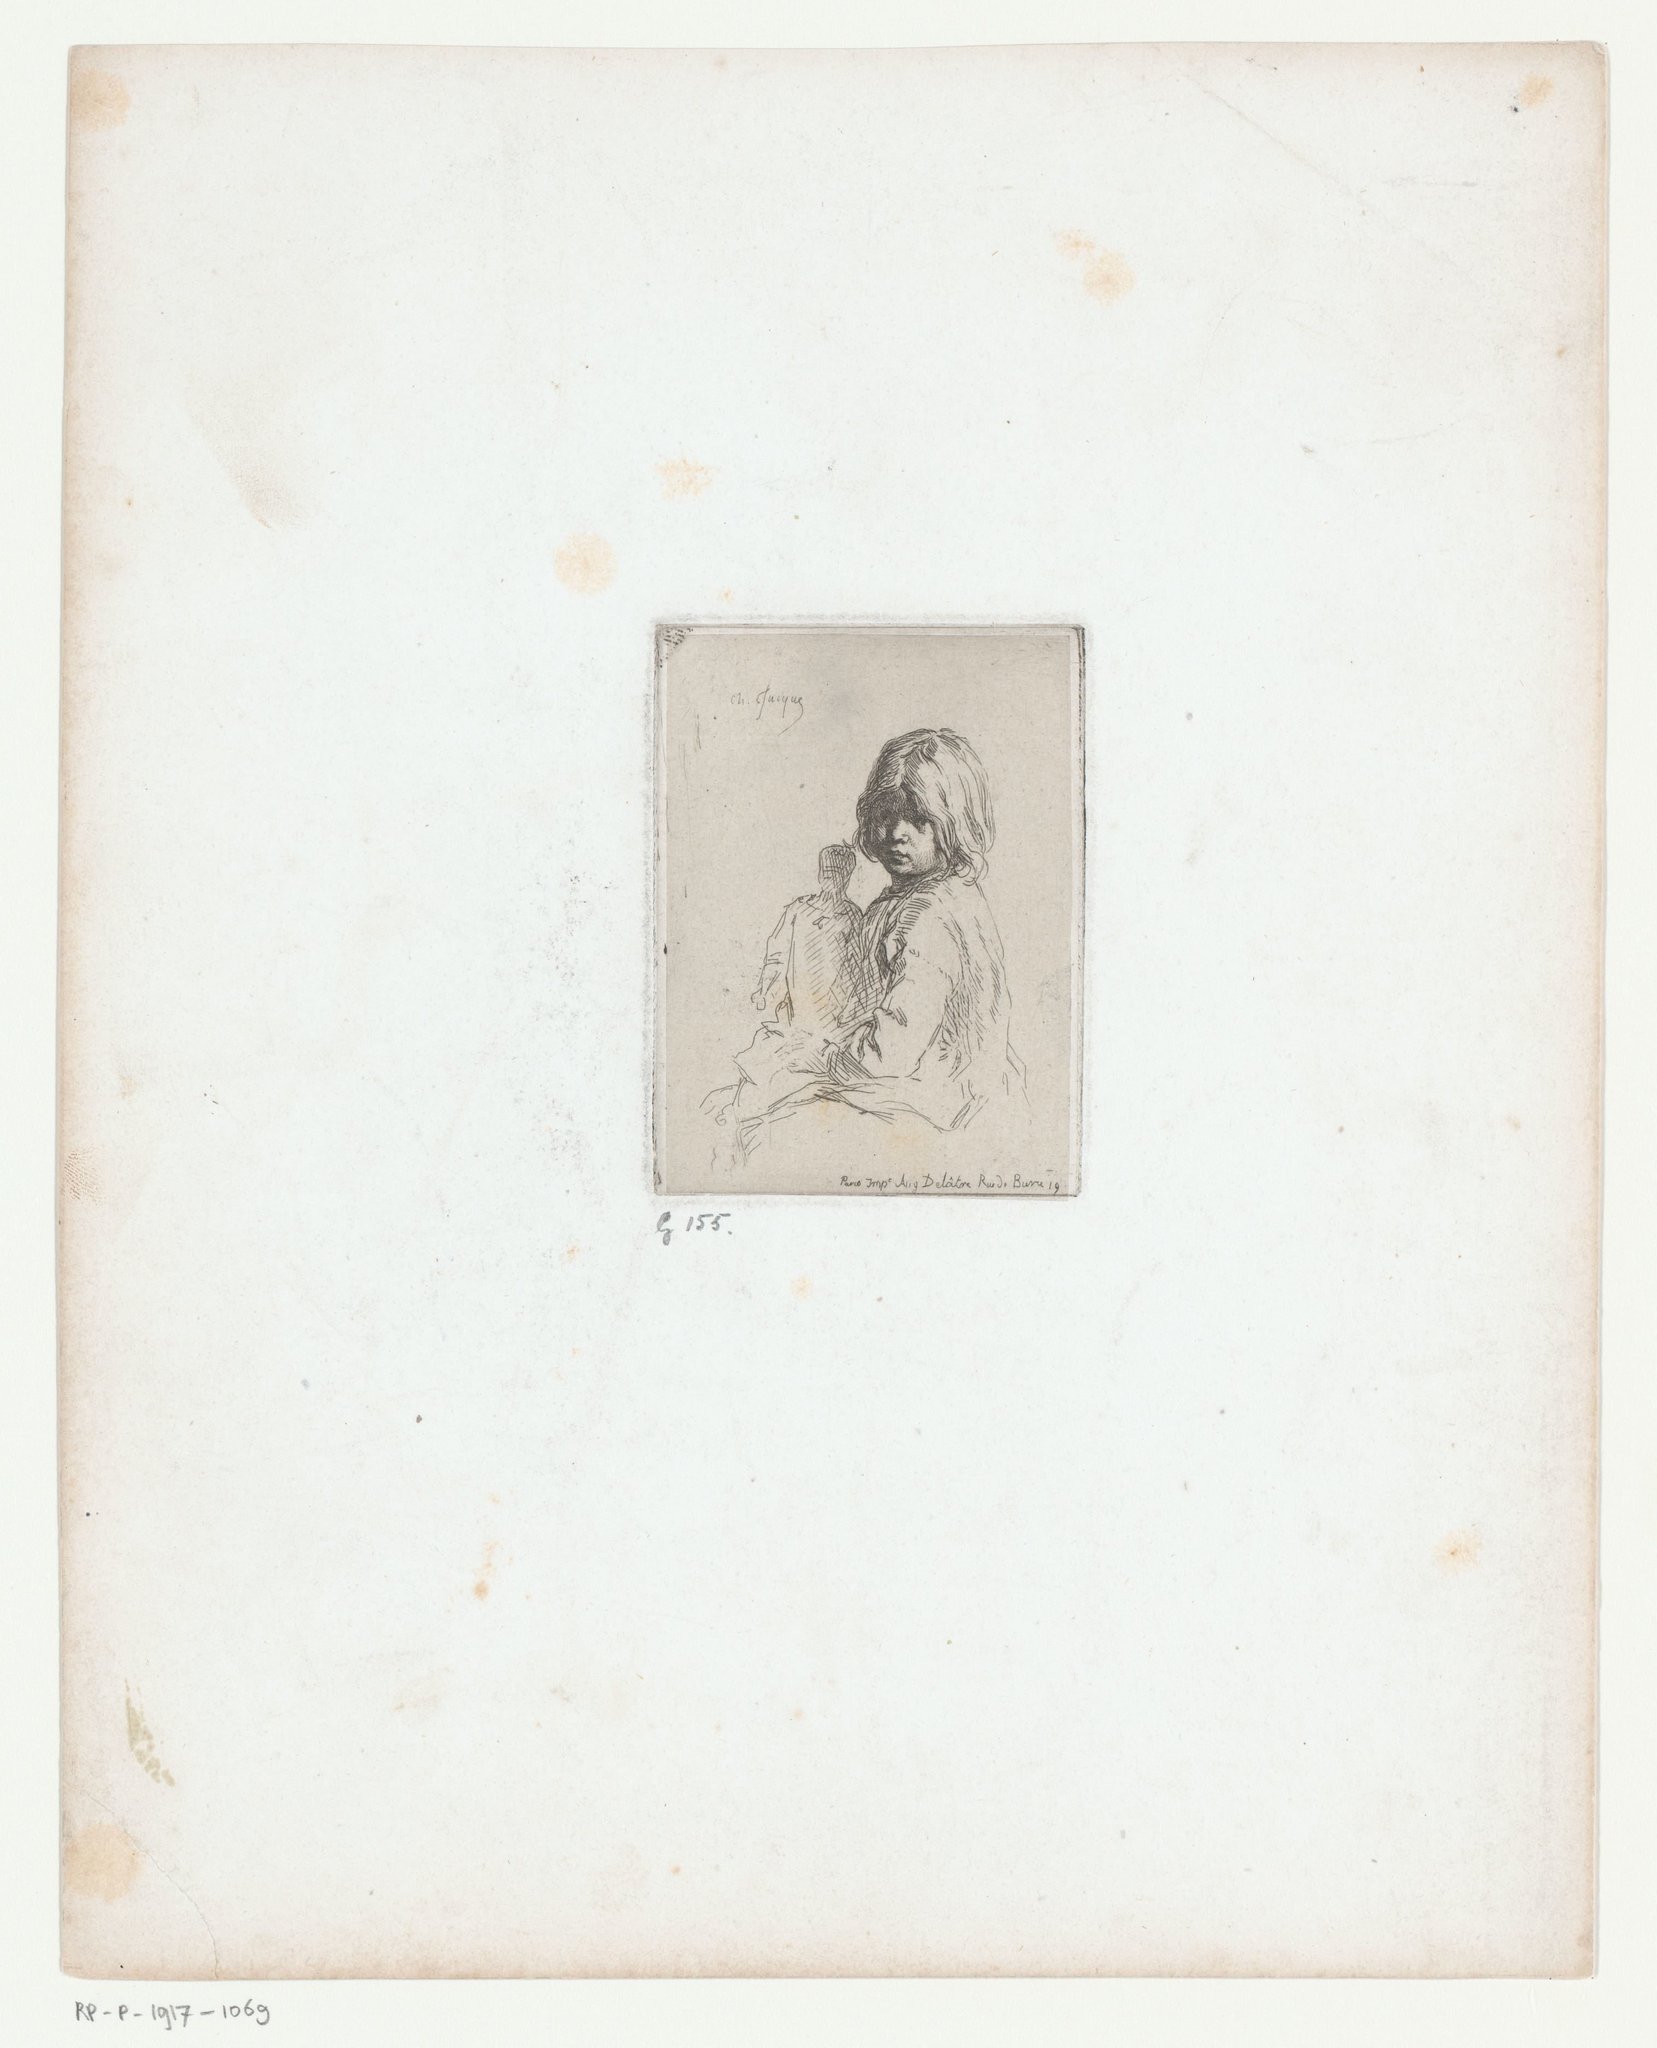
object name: print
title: Portret van de dochter van de kunstenaar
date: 1850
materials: paper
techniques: etching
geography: paris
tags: historical persons, (playing with) dolls, toddler - aa - girl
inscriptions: collector's mark: Lugt 2233